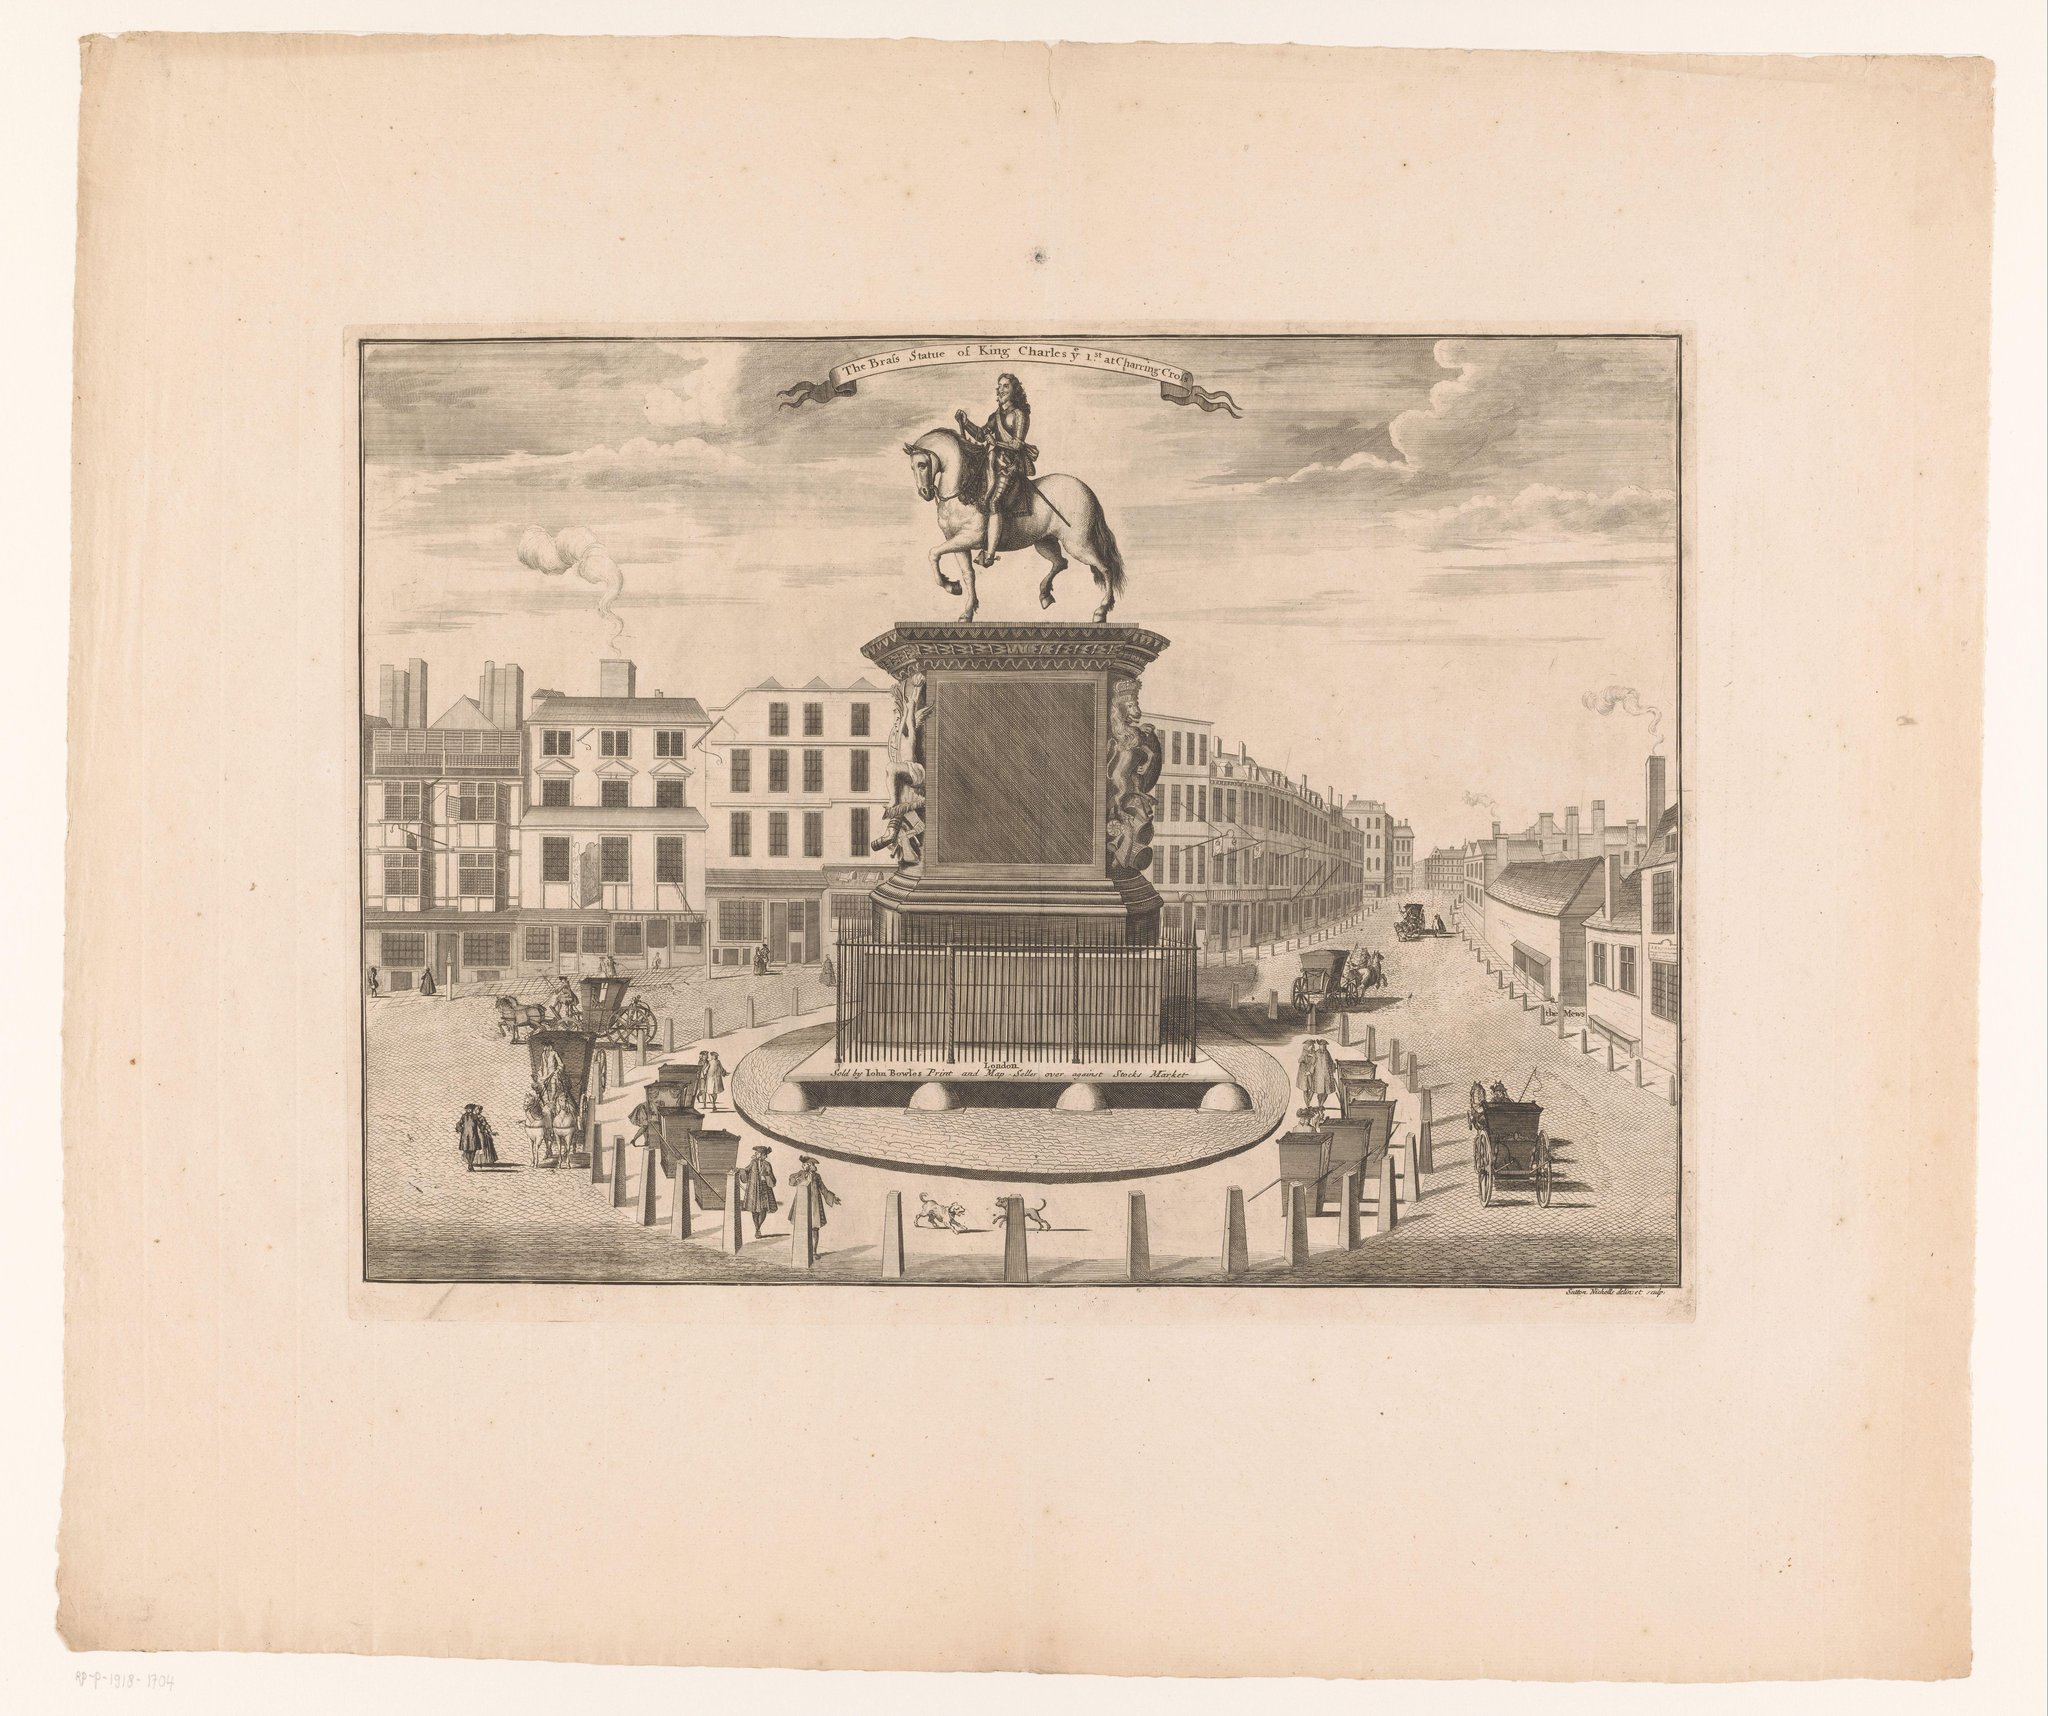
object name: print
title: Gezicht op het monument met het beeld van Karel I, koning van Engeland op Charing Cross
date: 1720-1731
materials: paper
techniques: engraving, etching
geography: london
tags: monument, statue, city-view in general; 'veduta' (+ city(-scape) with figures, staffage), london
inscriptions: collector's mark: Lugt 2233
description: Deze reeks werd voor het eerst compleet uitgegeven in 1731, al zijn de losse prenten al voor die tijd uitgebracht. De meeste prenten zijn vervaardigd door Sutton Nicholls. De serie werd aangeboden voor verkoop door John Bowles in zijn catalogus 1753, op pagina 76, nummer 16.